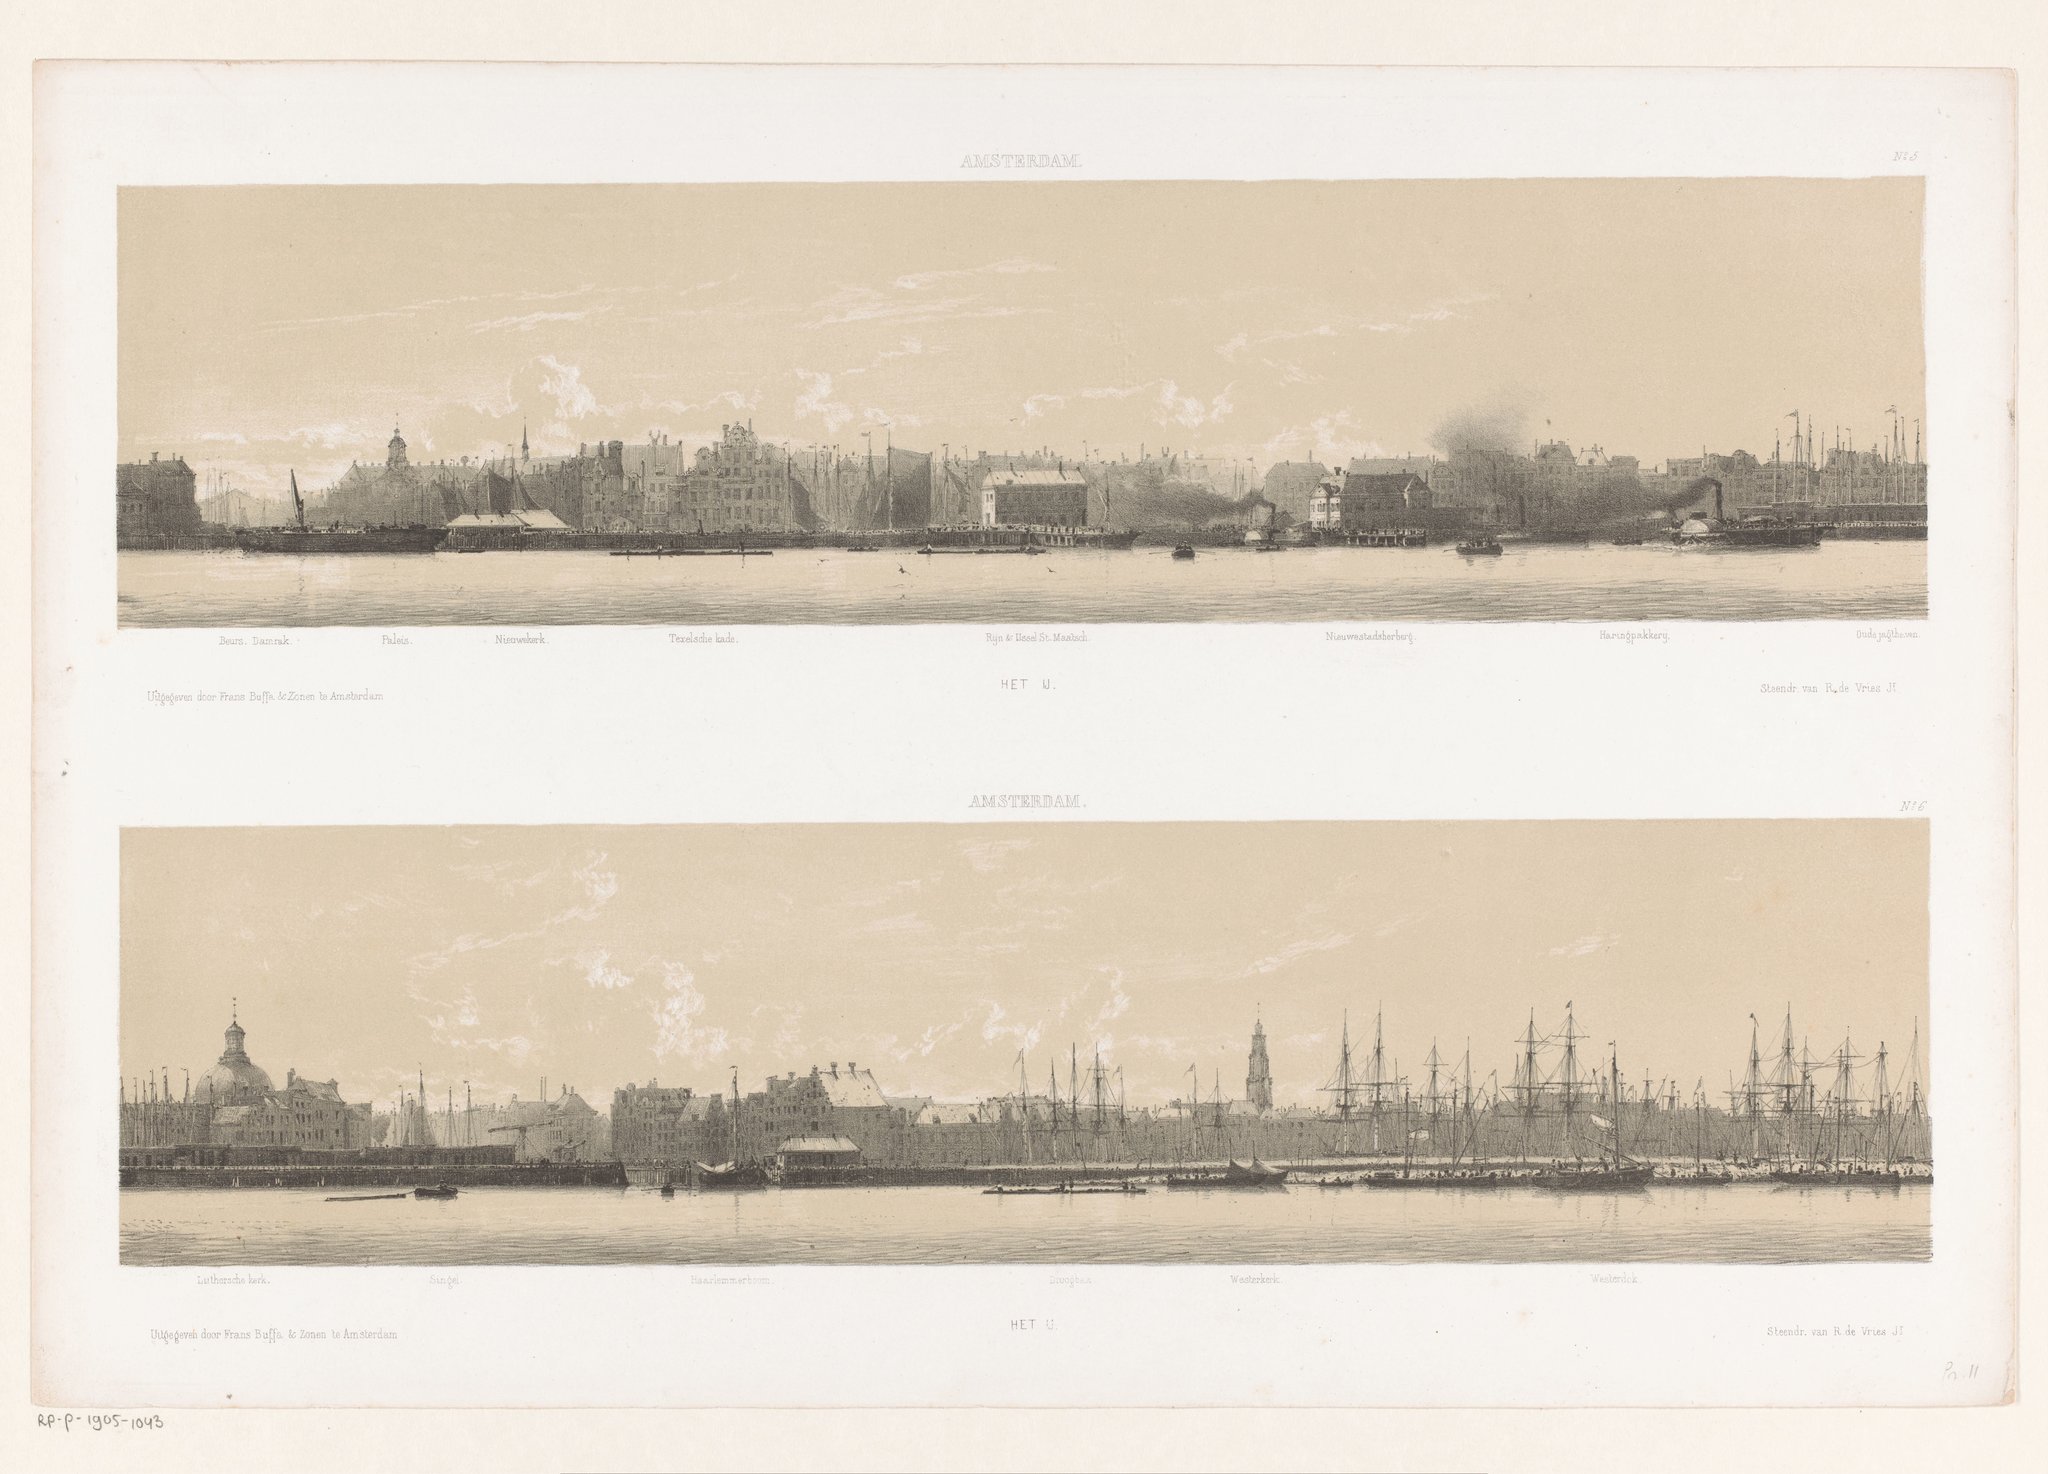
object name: print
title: Panorama d'Amsterdam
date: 1860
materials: paper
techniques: tone lithography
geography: amsterdam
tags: prospect of city, town panorama, silhouette of city, amsterdam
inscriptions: collector's mark: Lugt 2228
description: De stad is vanaf het IJ gezien. In het bovenste profiel zijn de Beurs, het Damrak, het Paleis op de Dam, de Nieuwe Kerk, de Texelse Kade, Rijn & IJssel Maatschappij, de Nieuwe Stadsherberg, de Haringpakkerij en de Oude Jachthaven afgebeeld. Het tweede profiel daaronder gaat door met de Lutherse Kerk, het Singel, de Haarlemmerboom, het Droogbak, de Westerkerk en het Westerdok. Beiden profielen zijn rechtsboven genummerd.